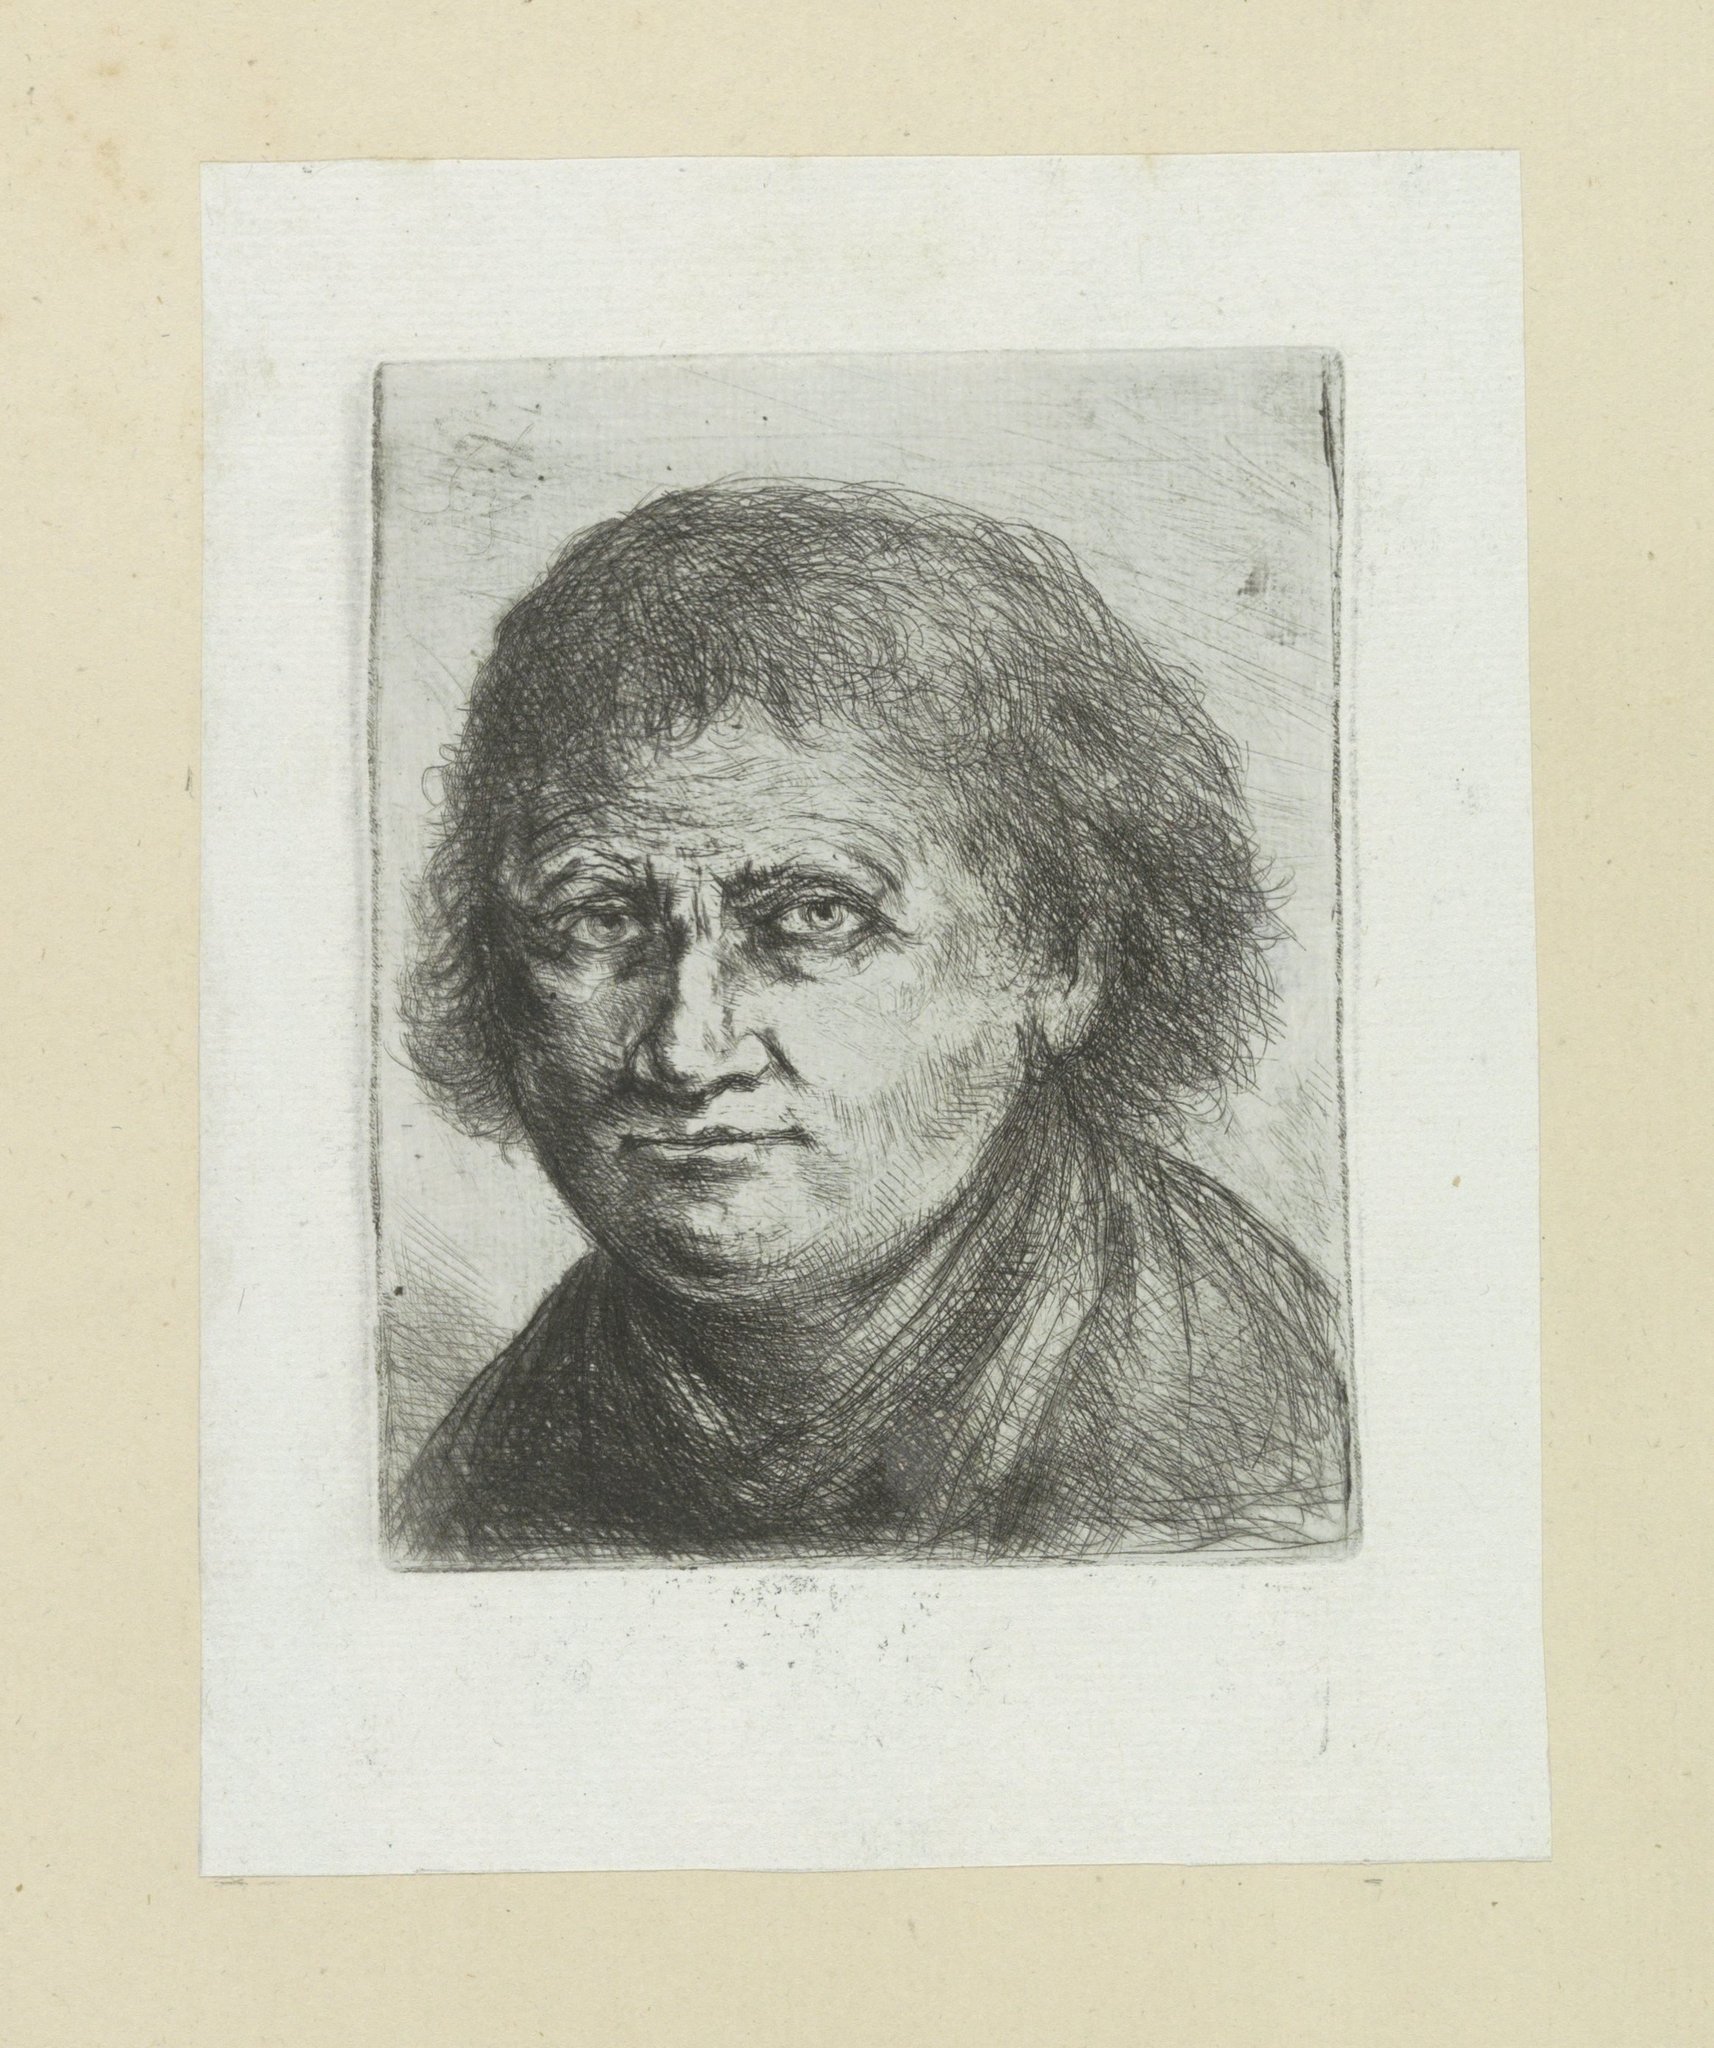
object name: print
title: The Compleat Work of Etchings by John Chalon / Oeuvre Complette des Eaux Fortes par Jean Chalon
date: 1802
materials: paper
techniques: drypoint, etching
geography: london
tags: morphology of human expression (+ adult male (human being))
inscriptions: collector's mark: ‘B’, collector's mark: ‘RIJKS / MUSM’